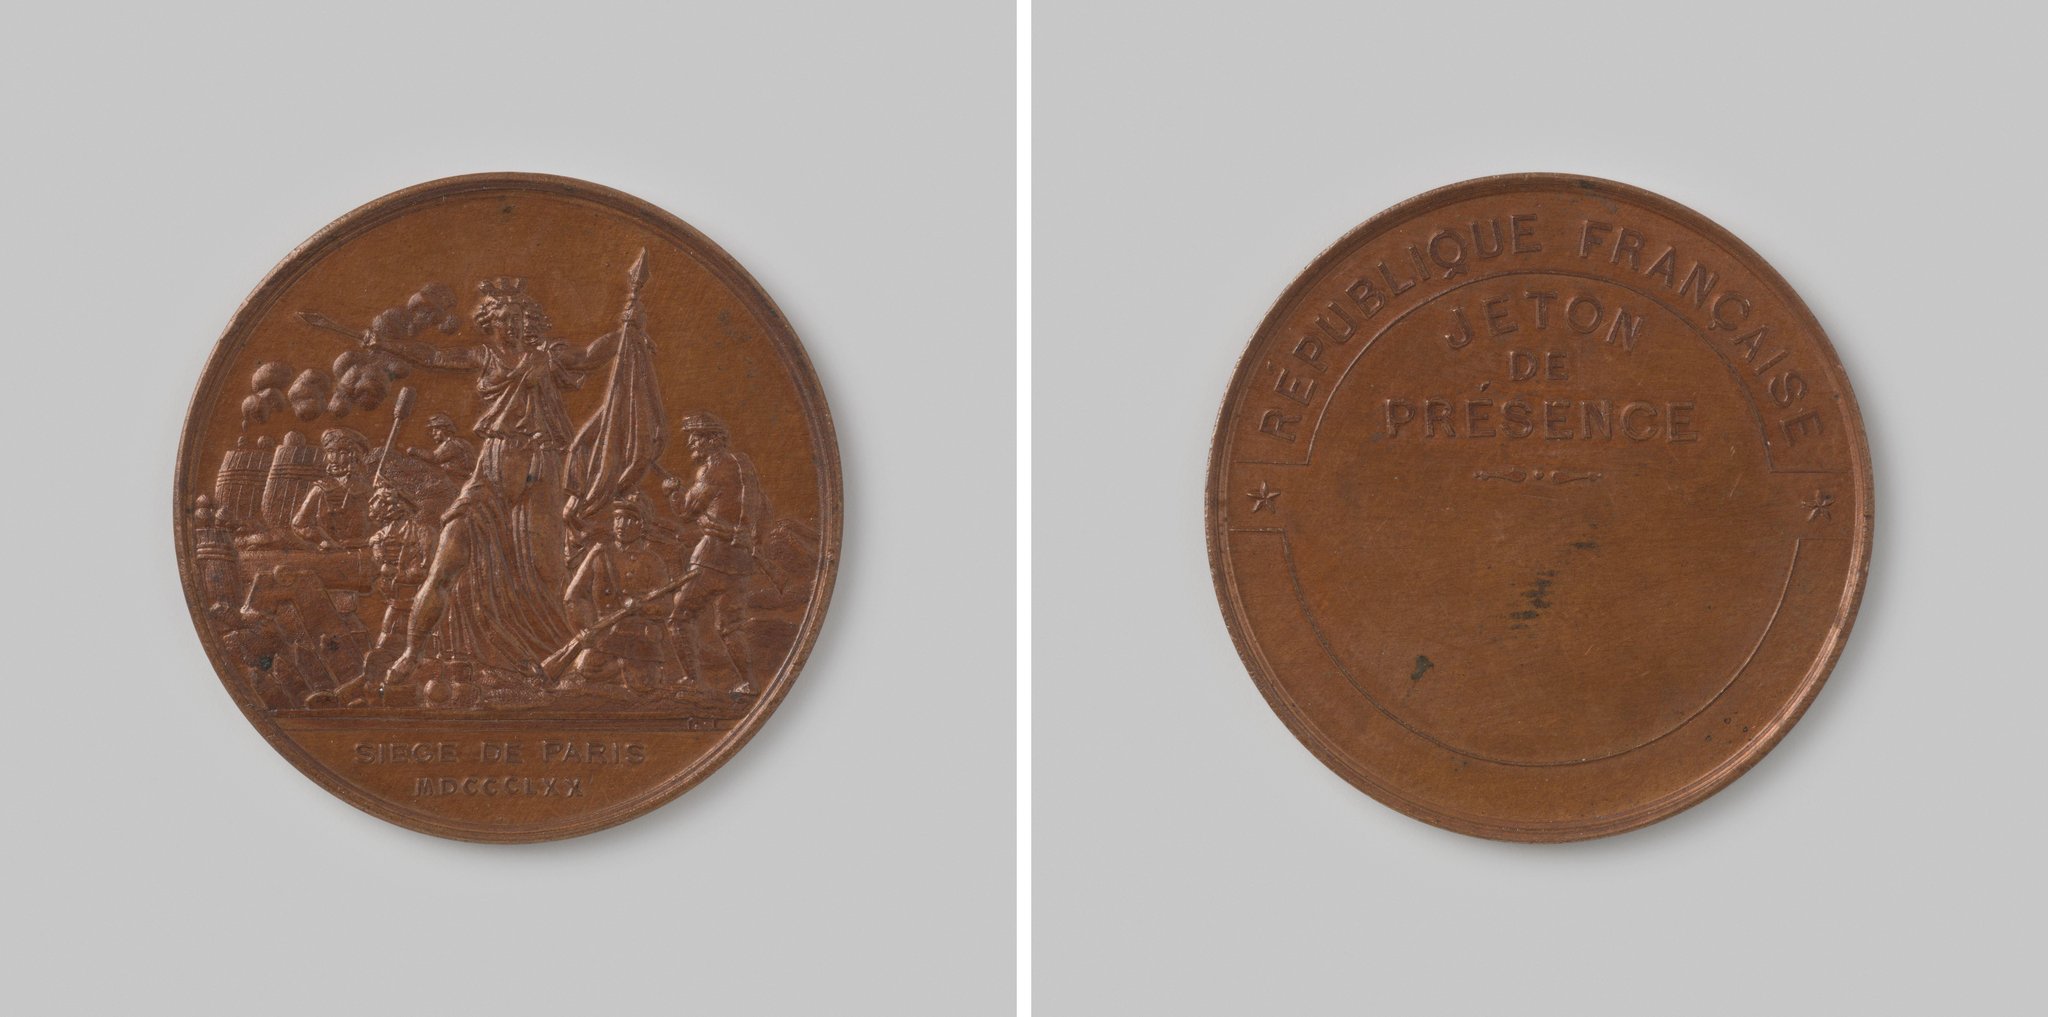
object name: history medal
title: Het beleg van Parijs, presentiepenning, 1870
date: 1870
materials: bronze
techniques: striking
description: Bronzen penning, op de voorzijde de stadsgodin van Parijs met zwaard en vlag tussen militairen bij een barricade, met afsnedetekst, op de keerzijde in het veld drie regels tekst, met omschrift.